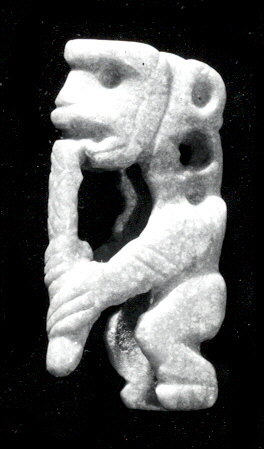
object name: pendant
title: Figure Pendant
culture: atlantic watershed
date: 1001-1600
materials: jade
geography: costa rica